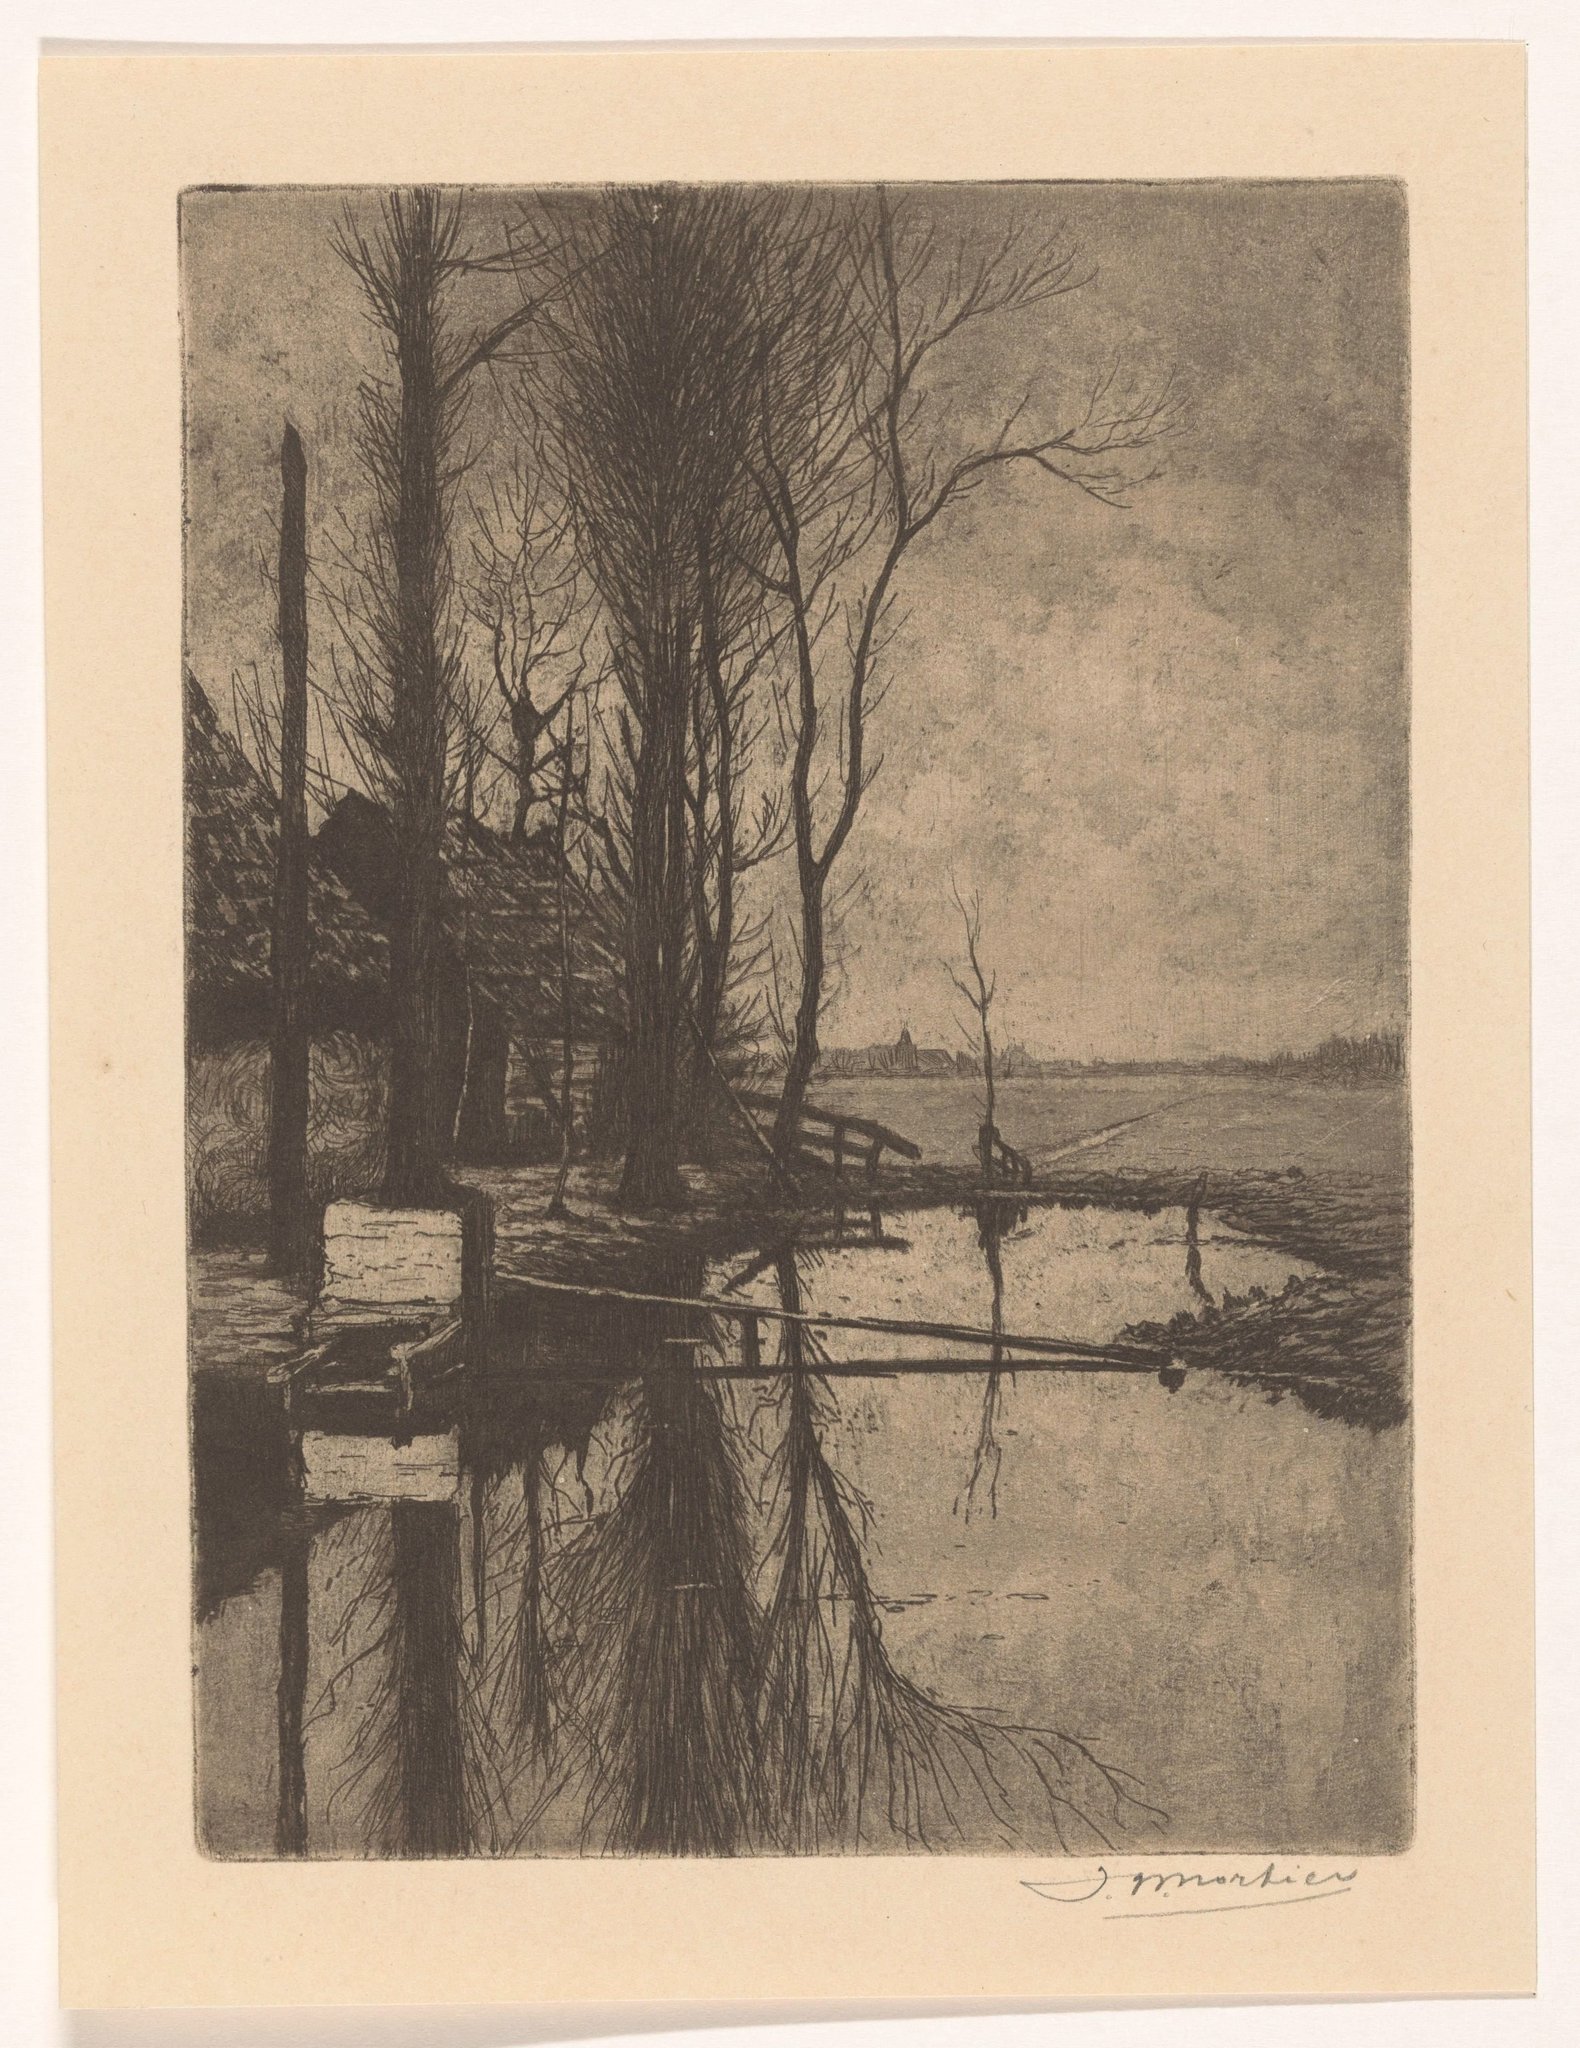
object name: print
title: Sloot bij Nootdorp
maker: jan willem nortier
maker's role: print maker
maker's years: 1864-1931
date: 1874-1919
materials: paper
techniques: etching, intaglio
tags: small canal, ditch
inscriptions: collector's mark: Lugt 2233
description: Links bomen naast een boerderij met schuur. Op de achtergrond weilanden.